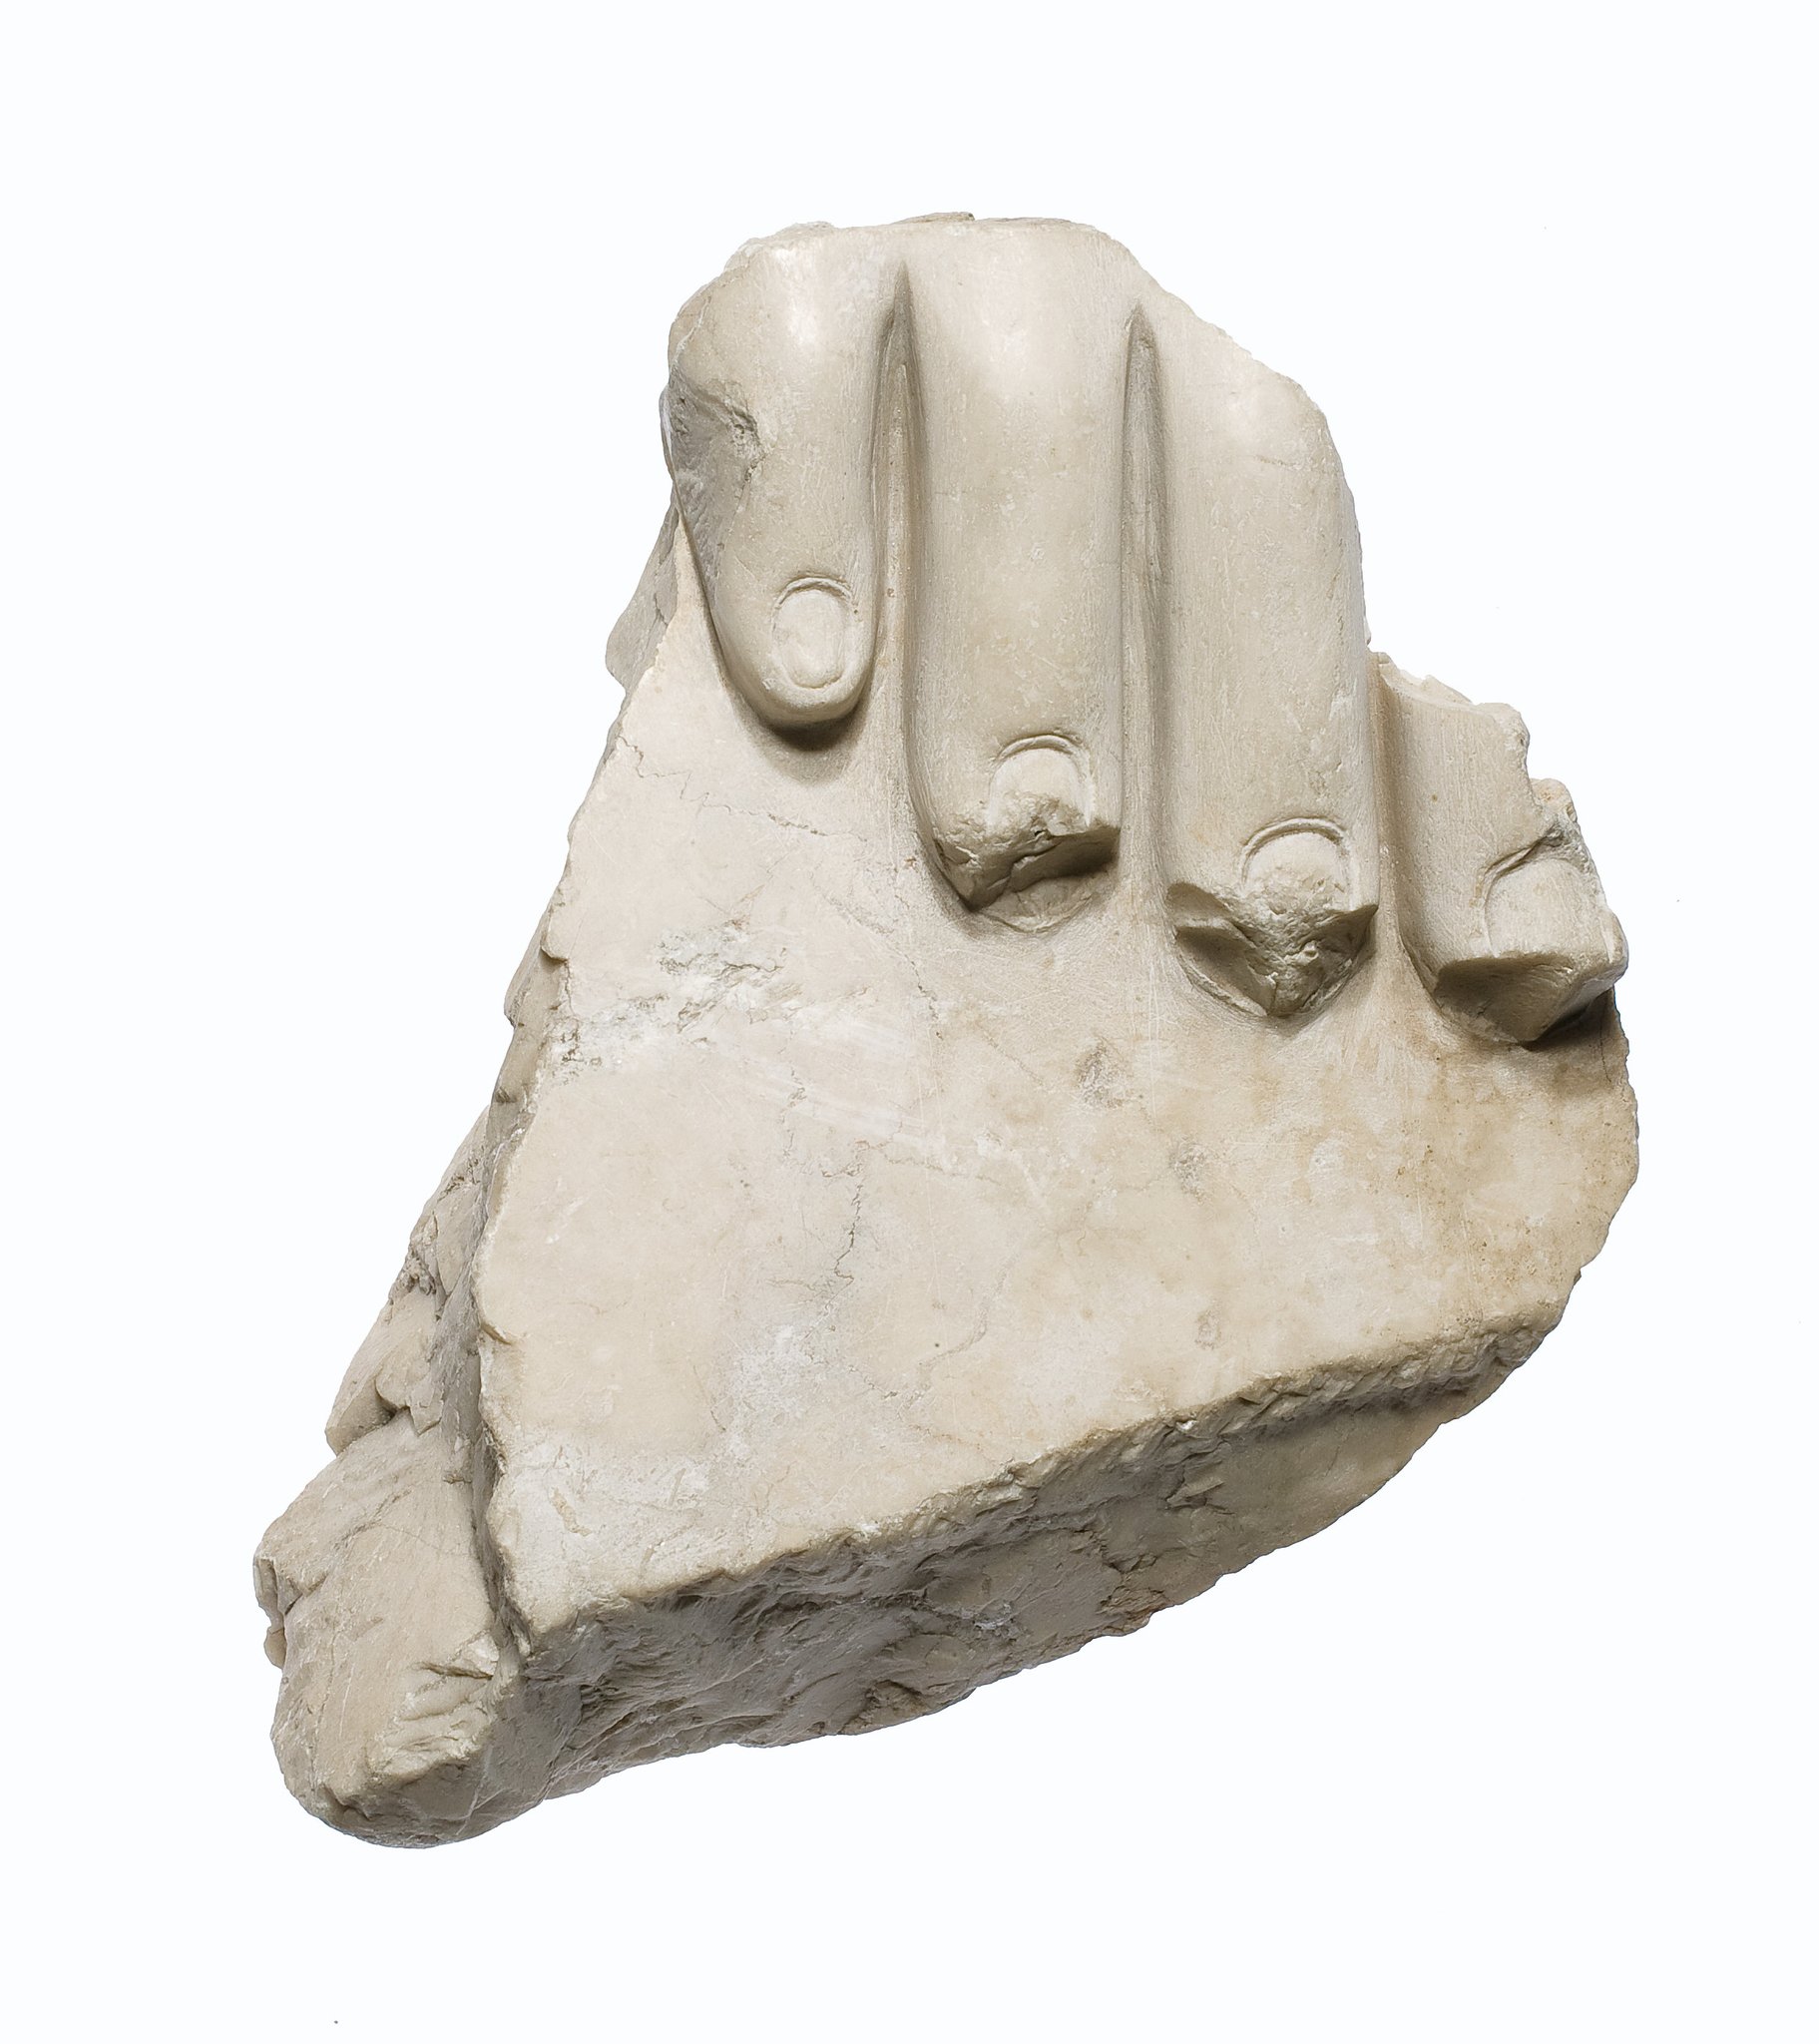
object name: foot fragment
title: Toe fragment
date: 1353-1336 BCE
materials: limestone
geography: egypt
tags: feet